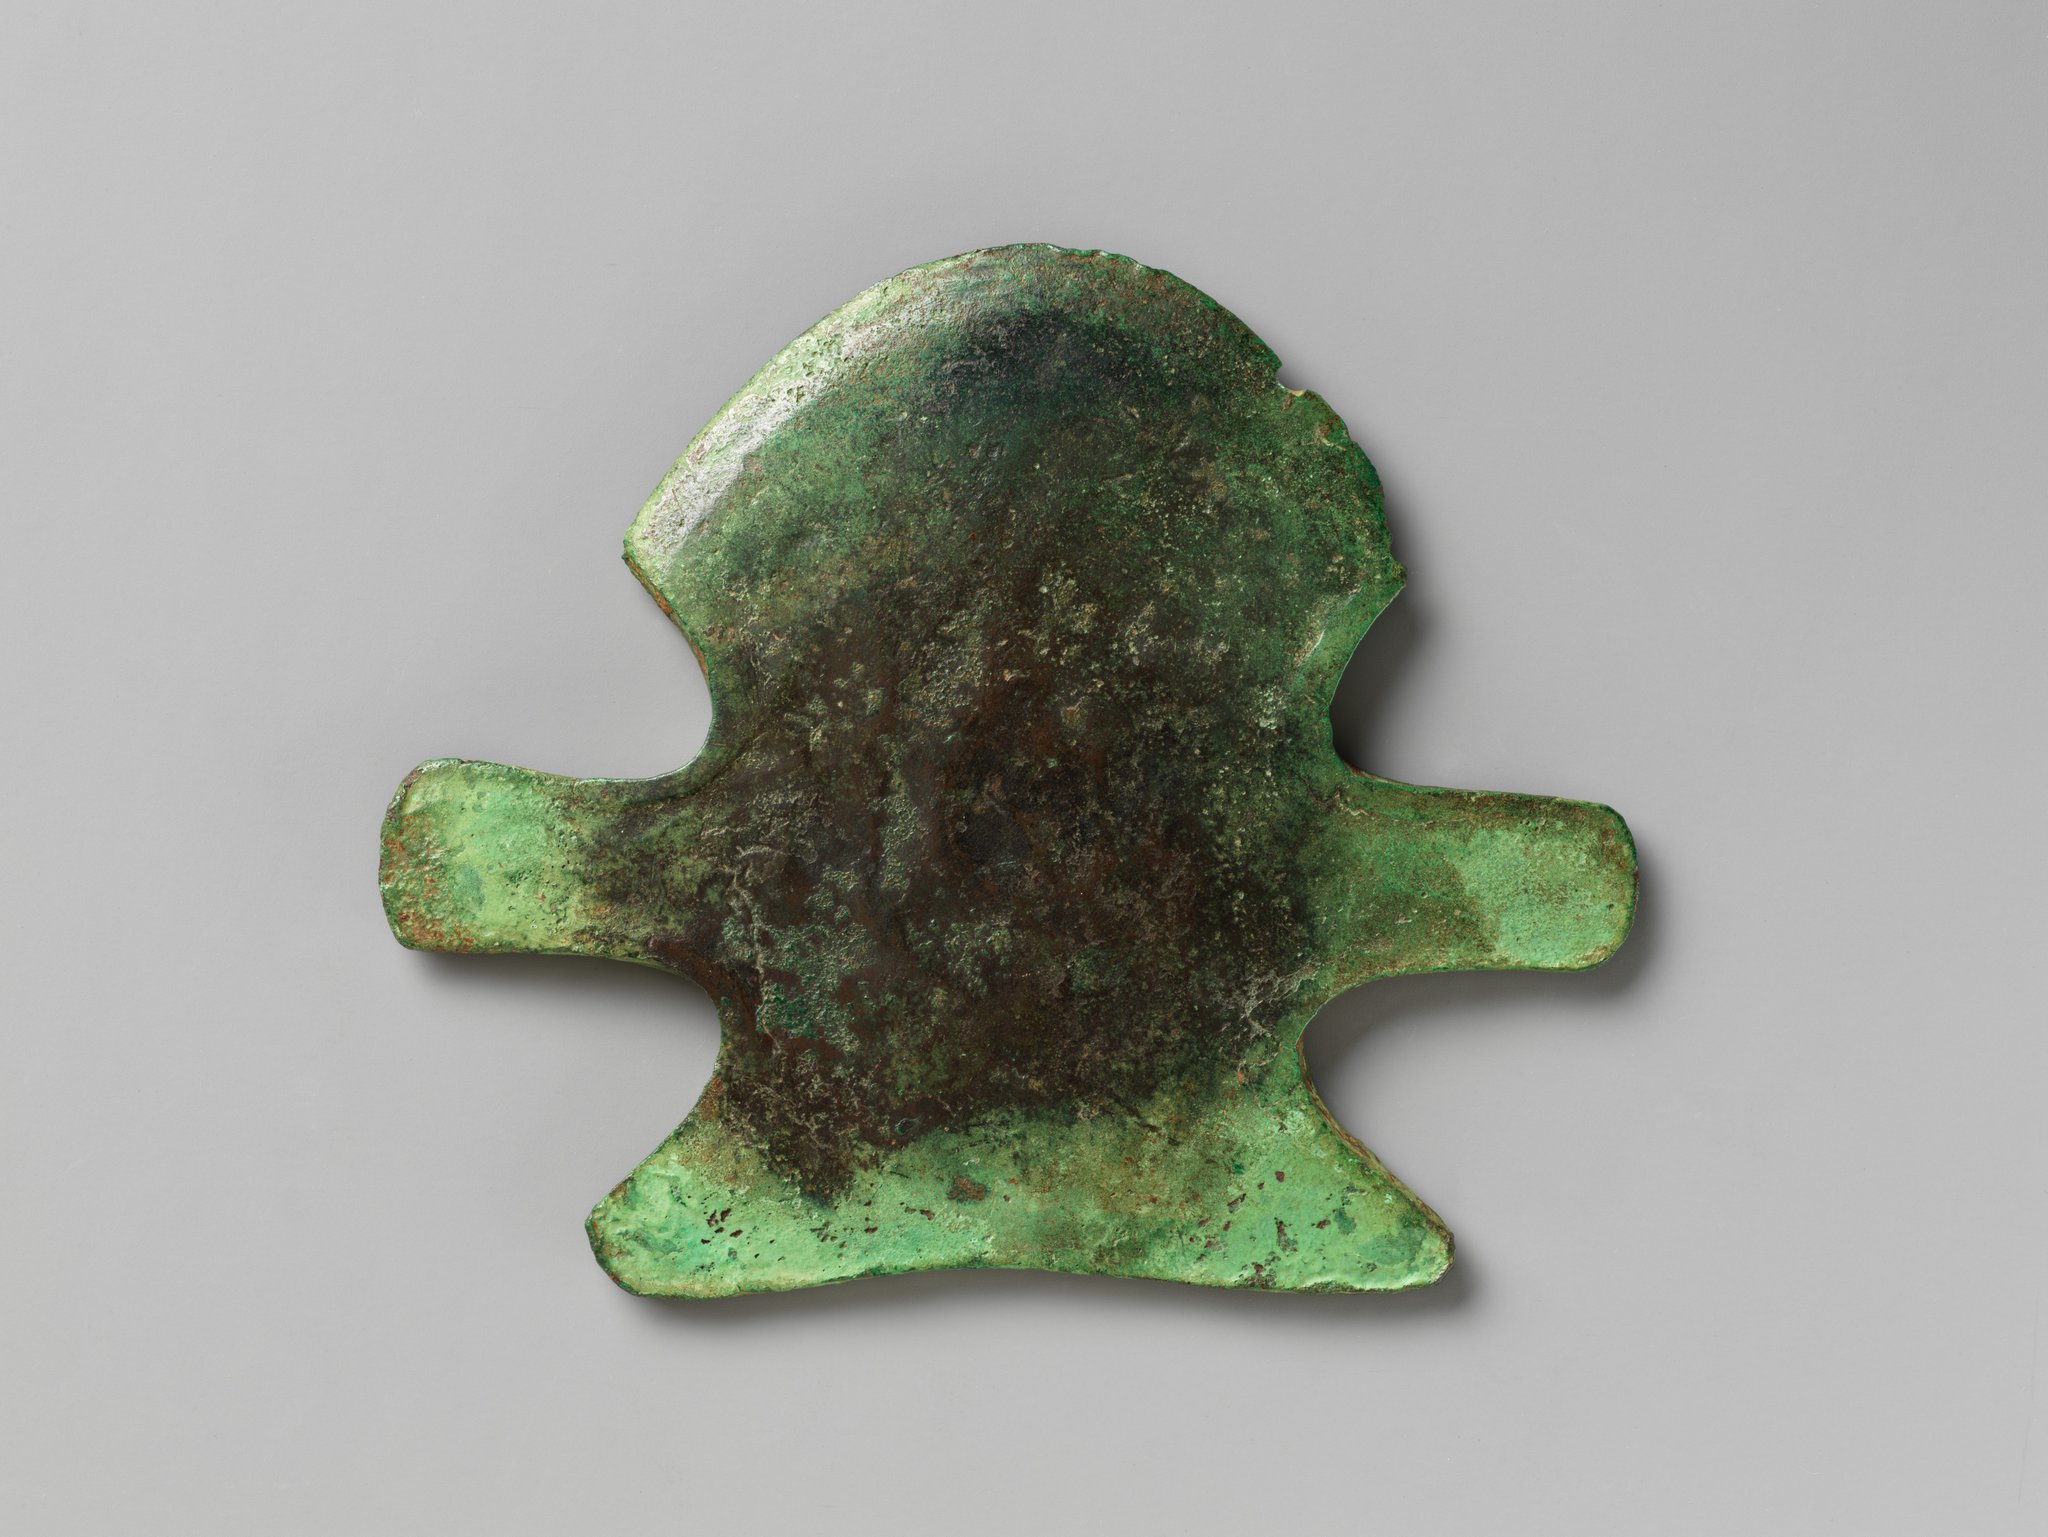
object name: anthropomorph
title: Eccentric Anthropomorph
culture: nepali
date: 1500-1000 BCE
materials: copper